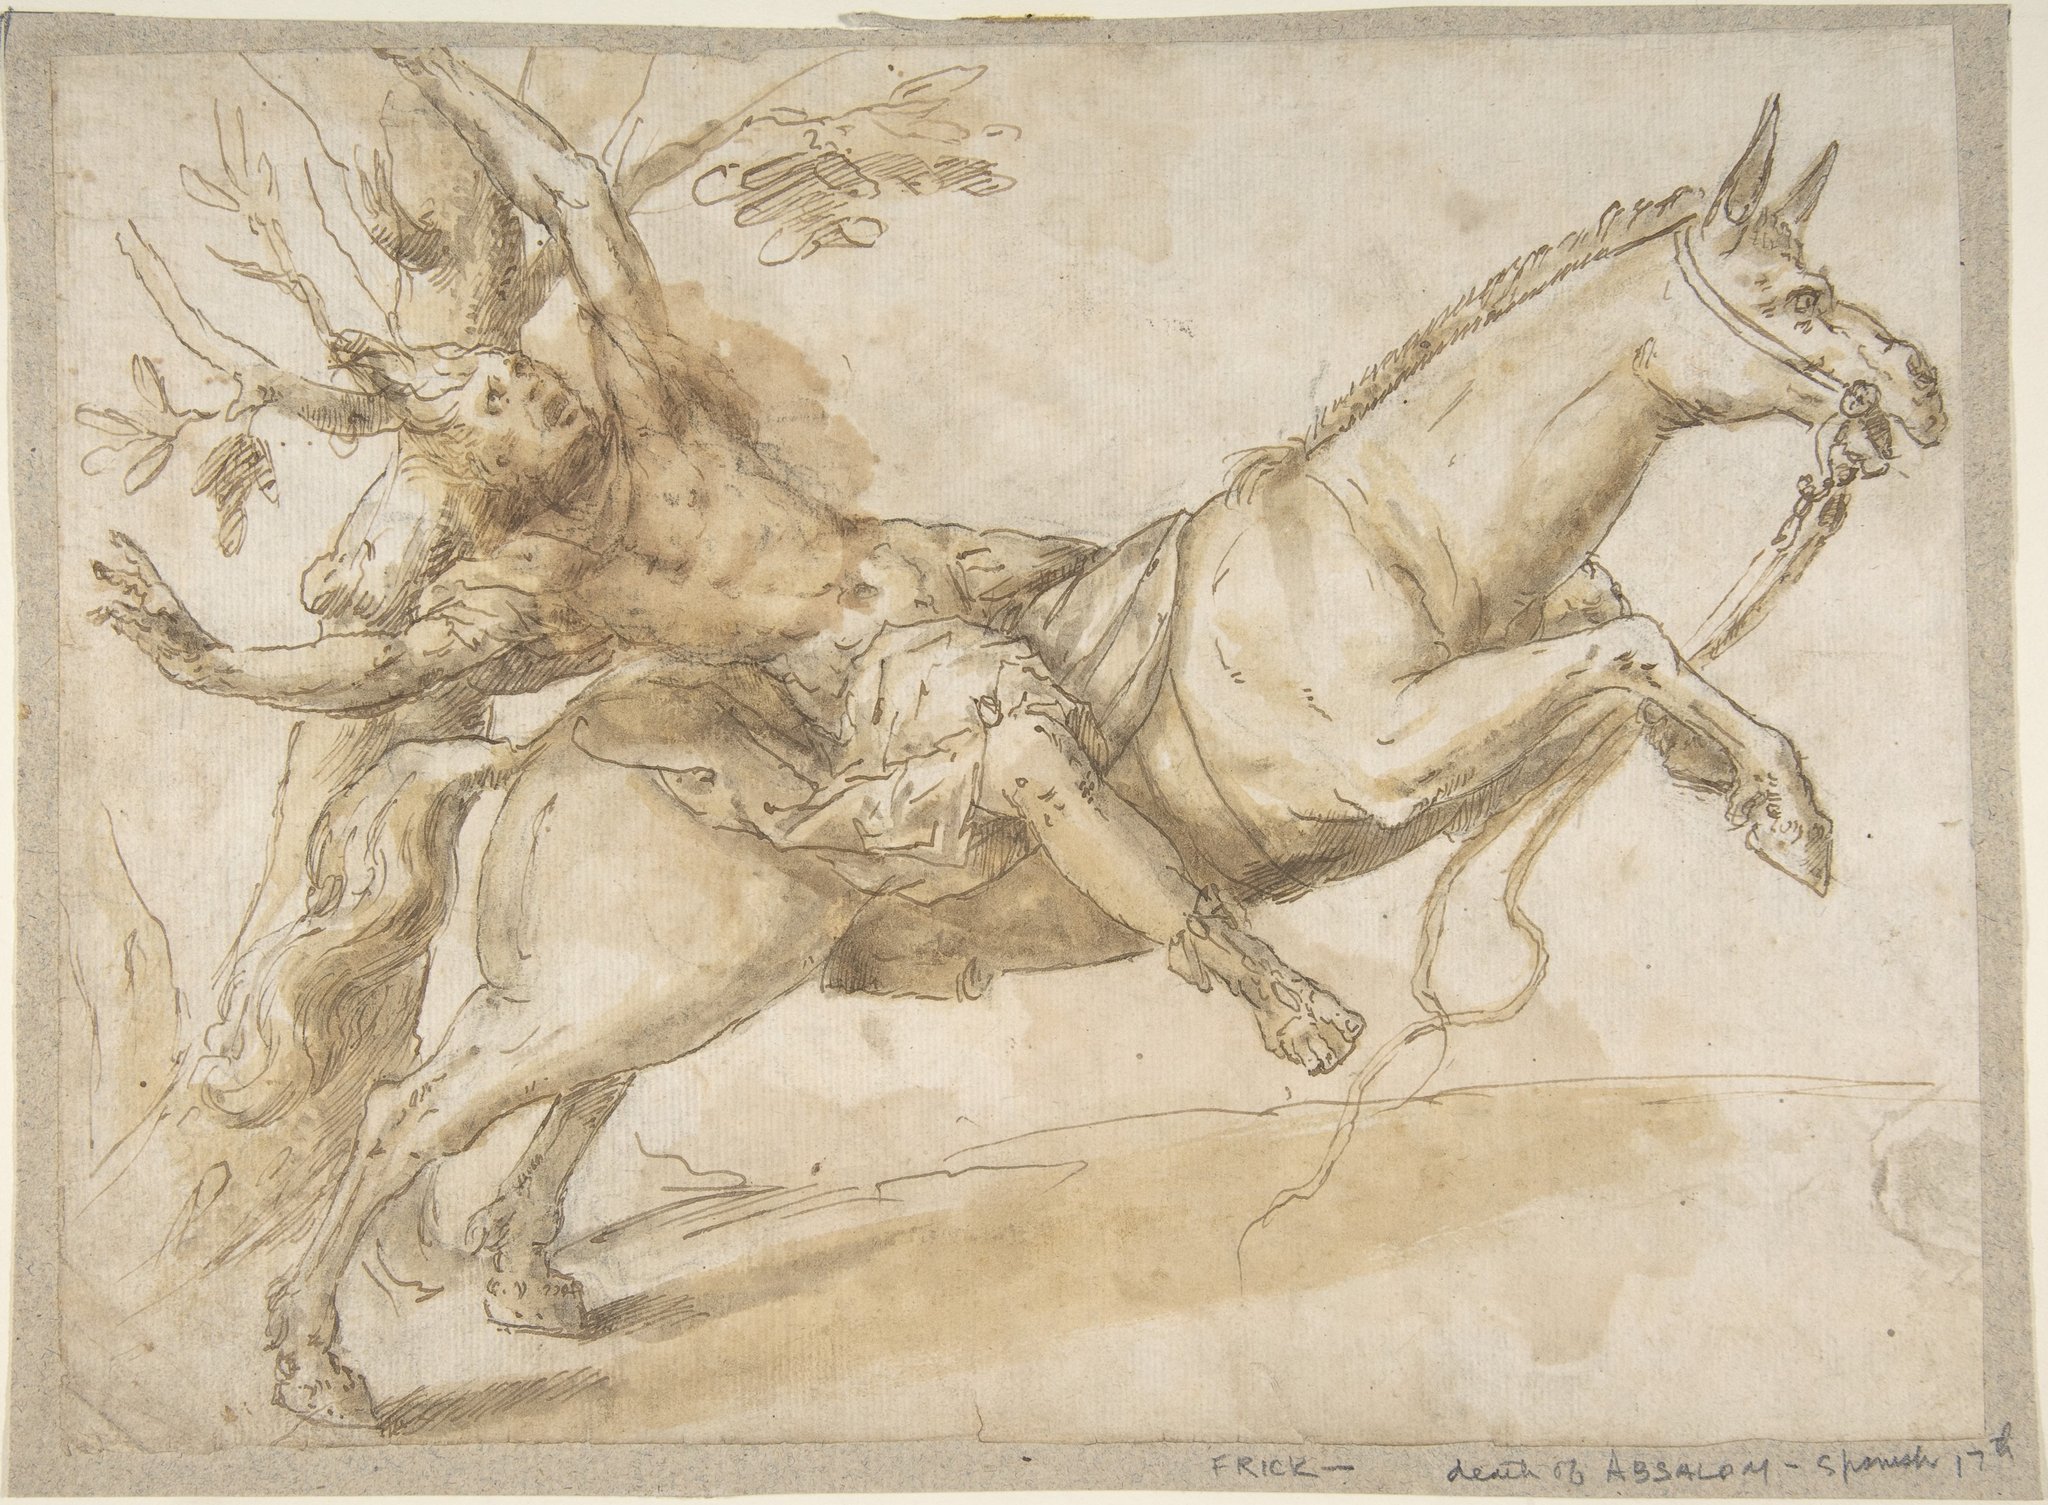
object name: drawing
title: Death of Absalom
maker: anonymous, spanish, school of seville, 17th century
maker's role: artist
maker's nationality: spanish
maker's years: 1600-1700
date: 1601-1700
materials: chalk, ink, paper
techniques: brush, pen, drawing, wash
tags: men,horses,death